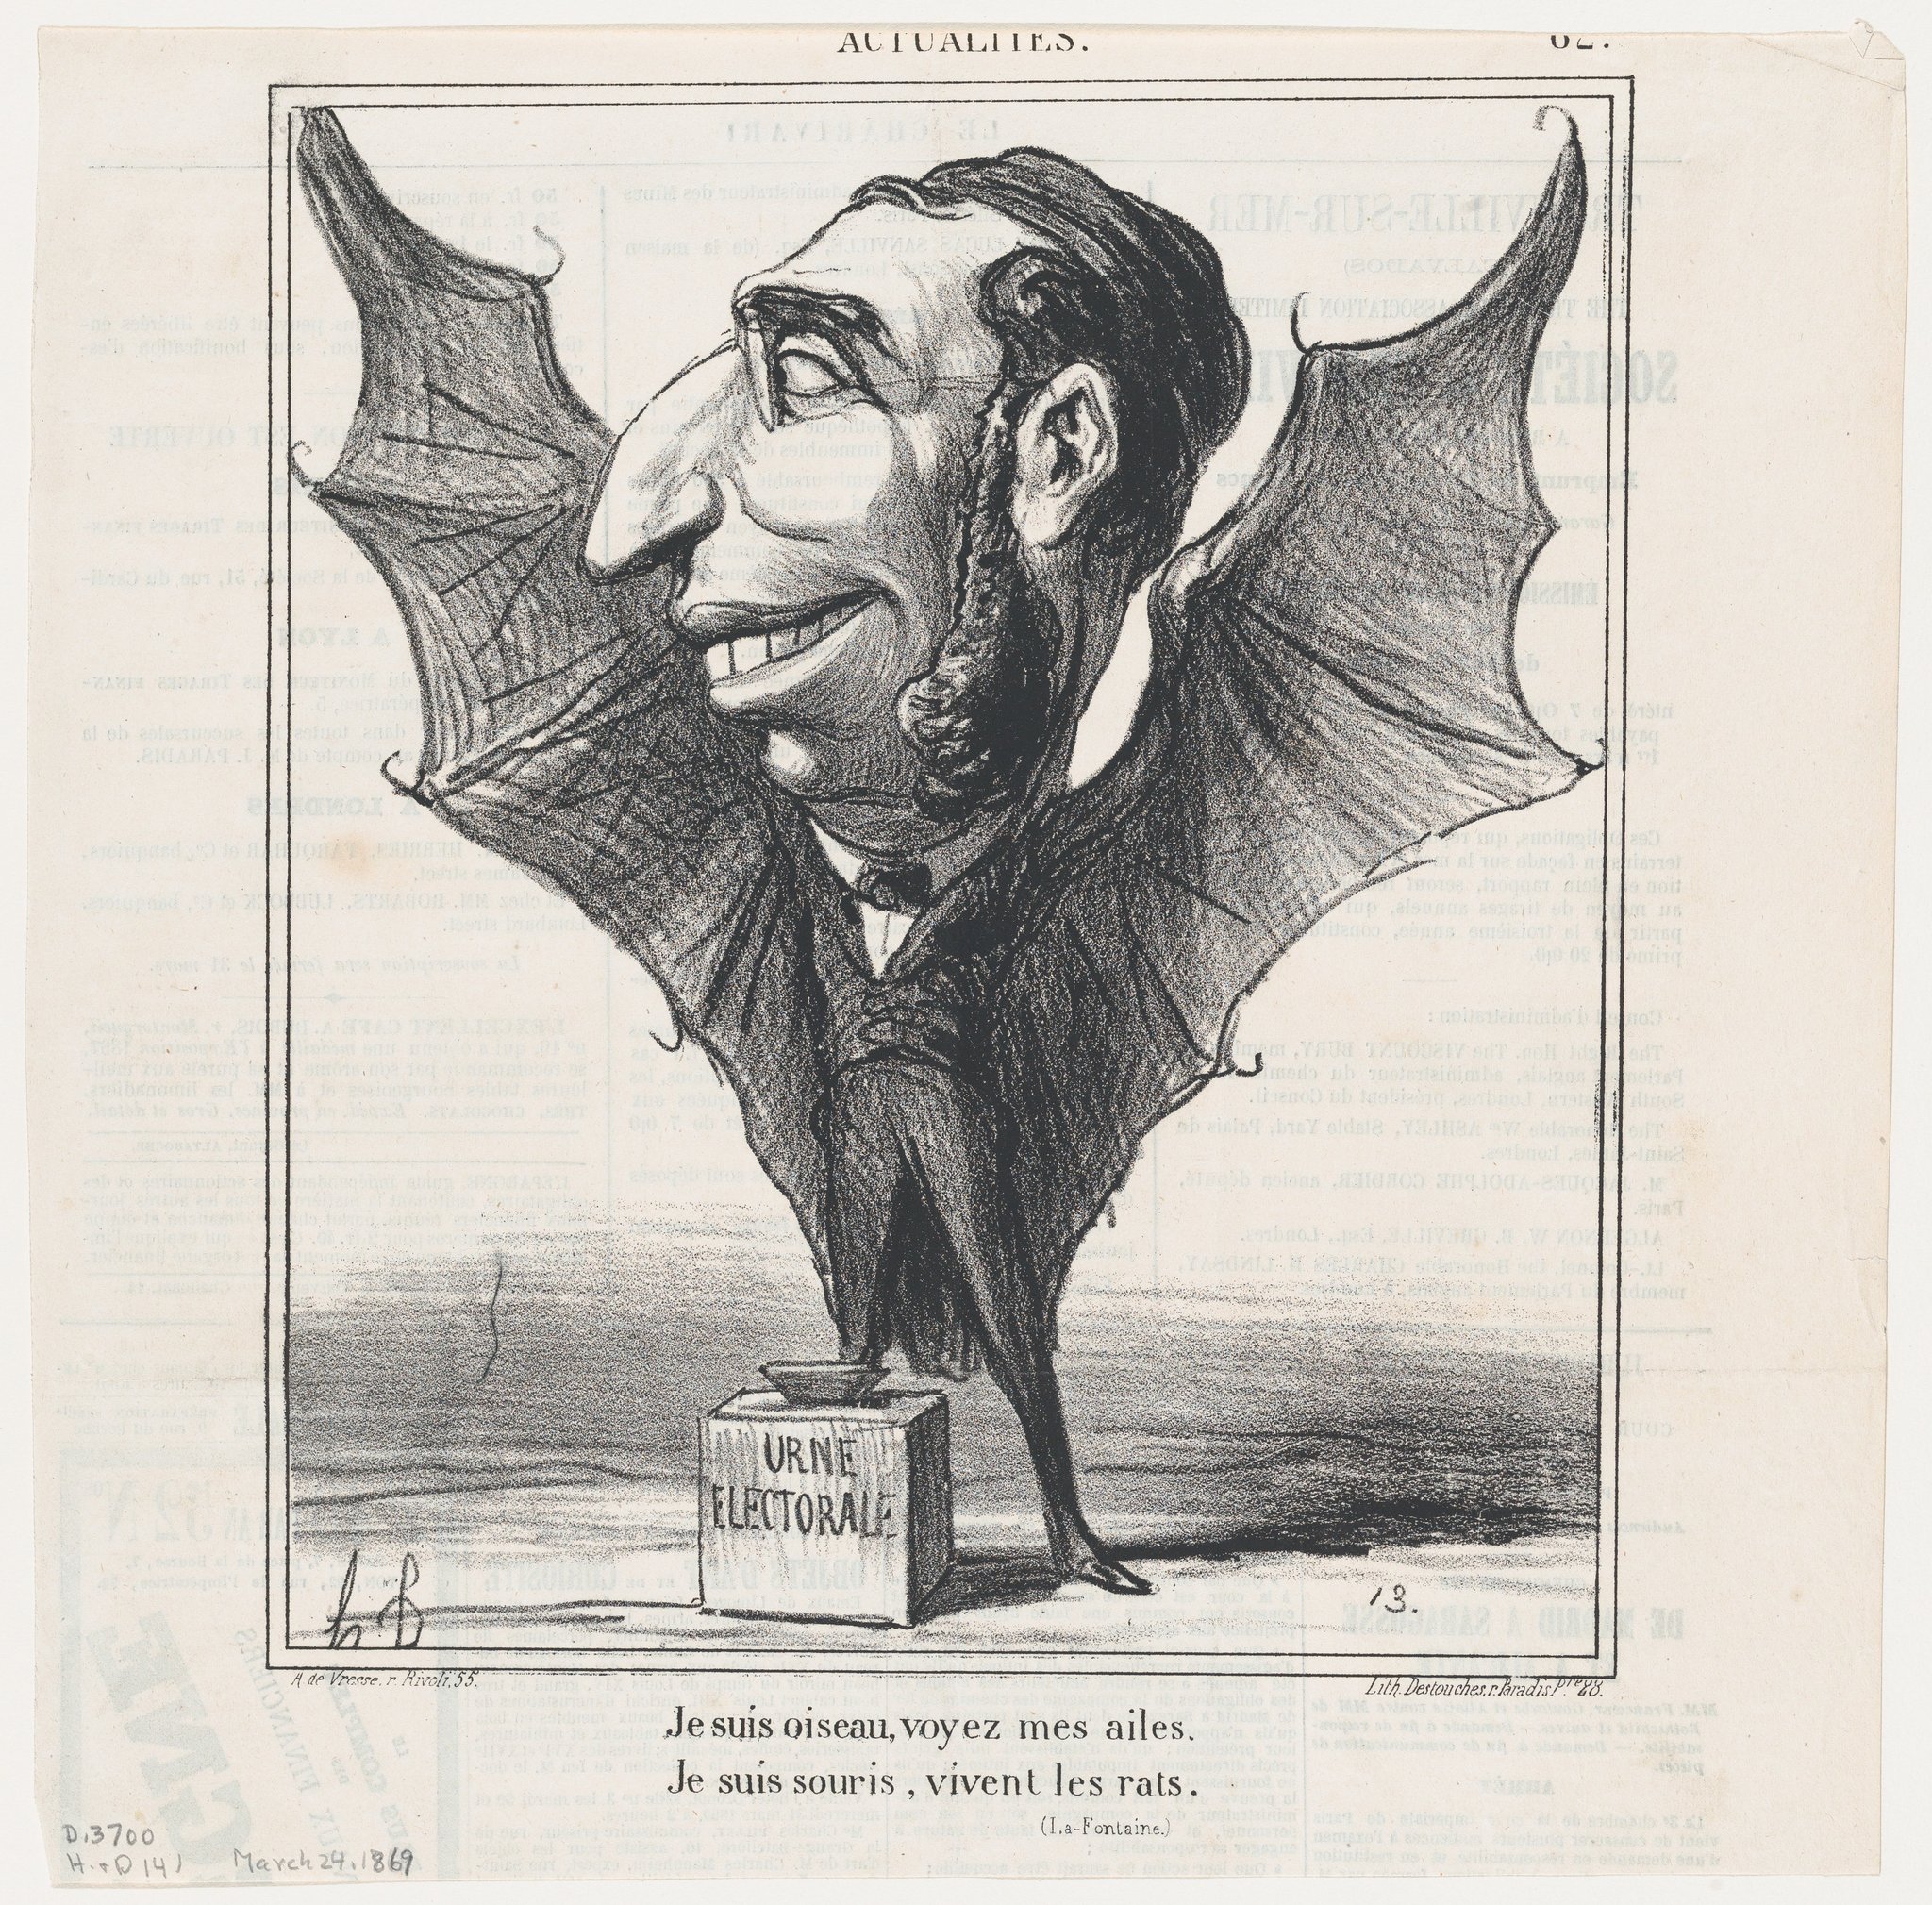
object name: print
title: I am a bird, see my wings. I am a bat, long live the rats (La Fontaine), from 'News of the day,' published in Le Charivari, March 24, 1869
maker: honoré daumier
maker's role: artist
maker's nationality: french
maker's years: 1808-1879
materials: paper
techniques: lithograph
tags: bats,satire,men